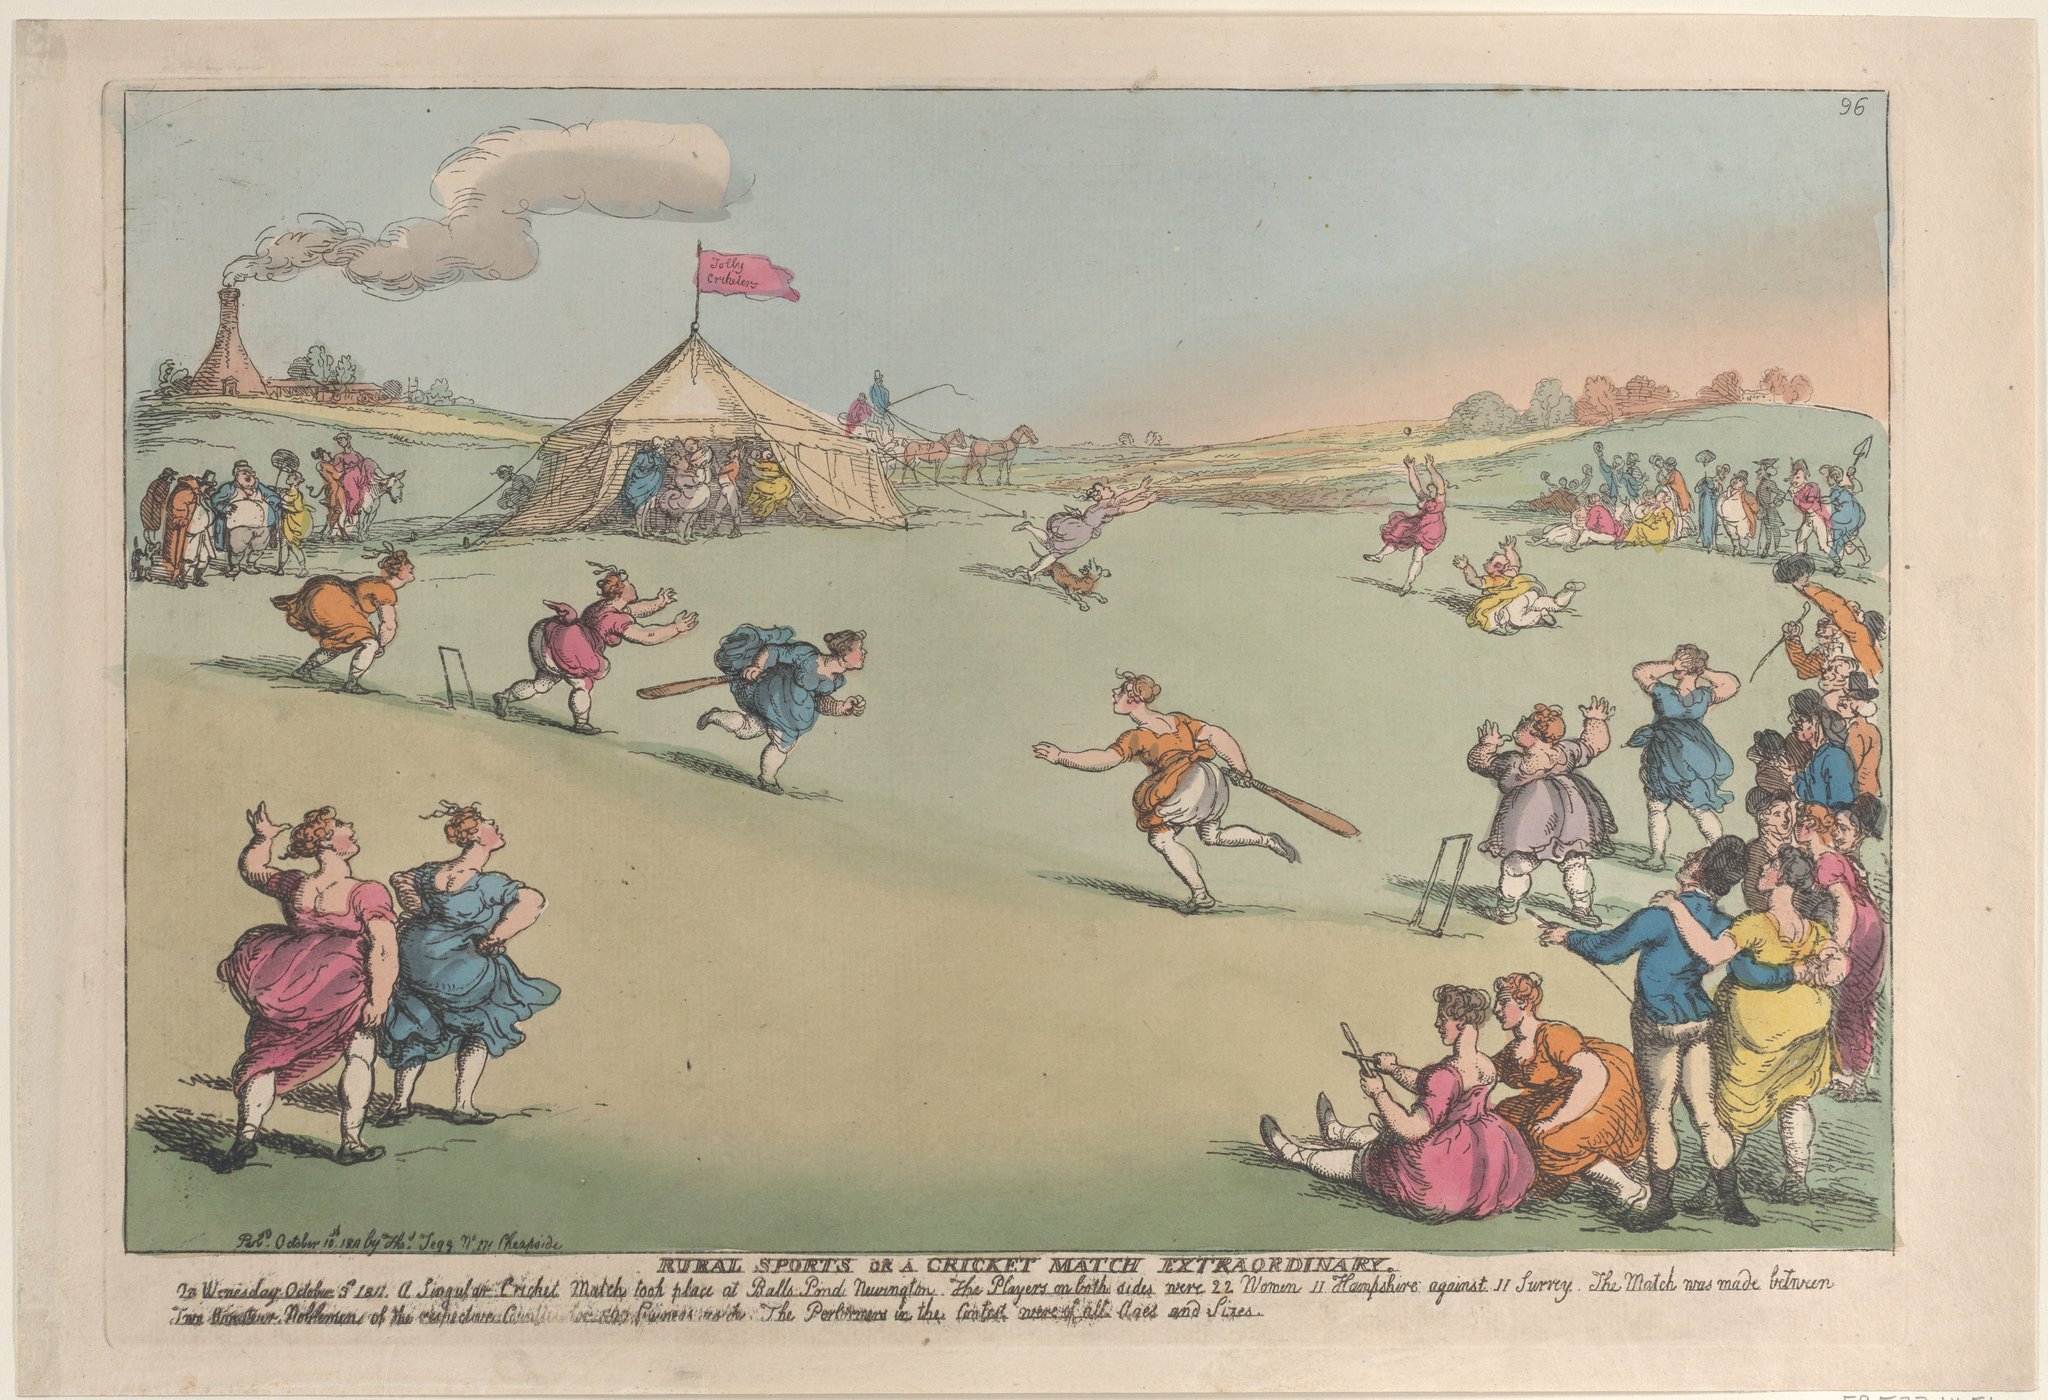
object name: print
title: Rural Sports or a Cricket Match Extraordinary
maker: thomas rowlandson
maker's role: artist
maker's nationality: british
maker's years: 1757-1827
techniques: etching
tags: satire,women,sports,games